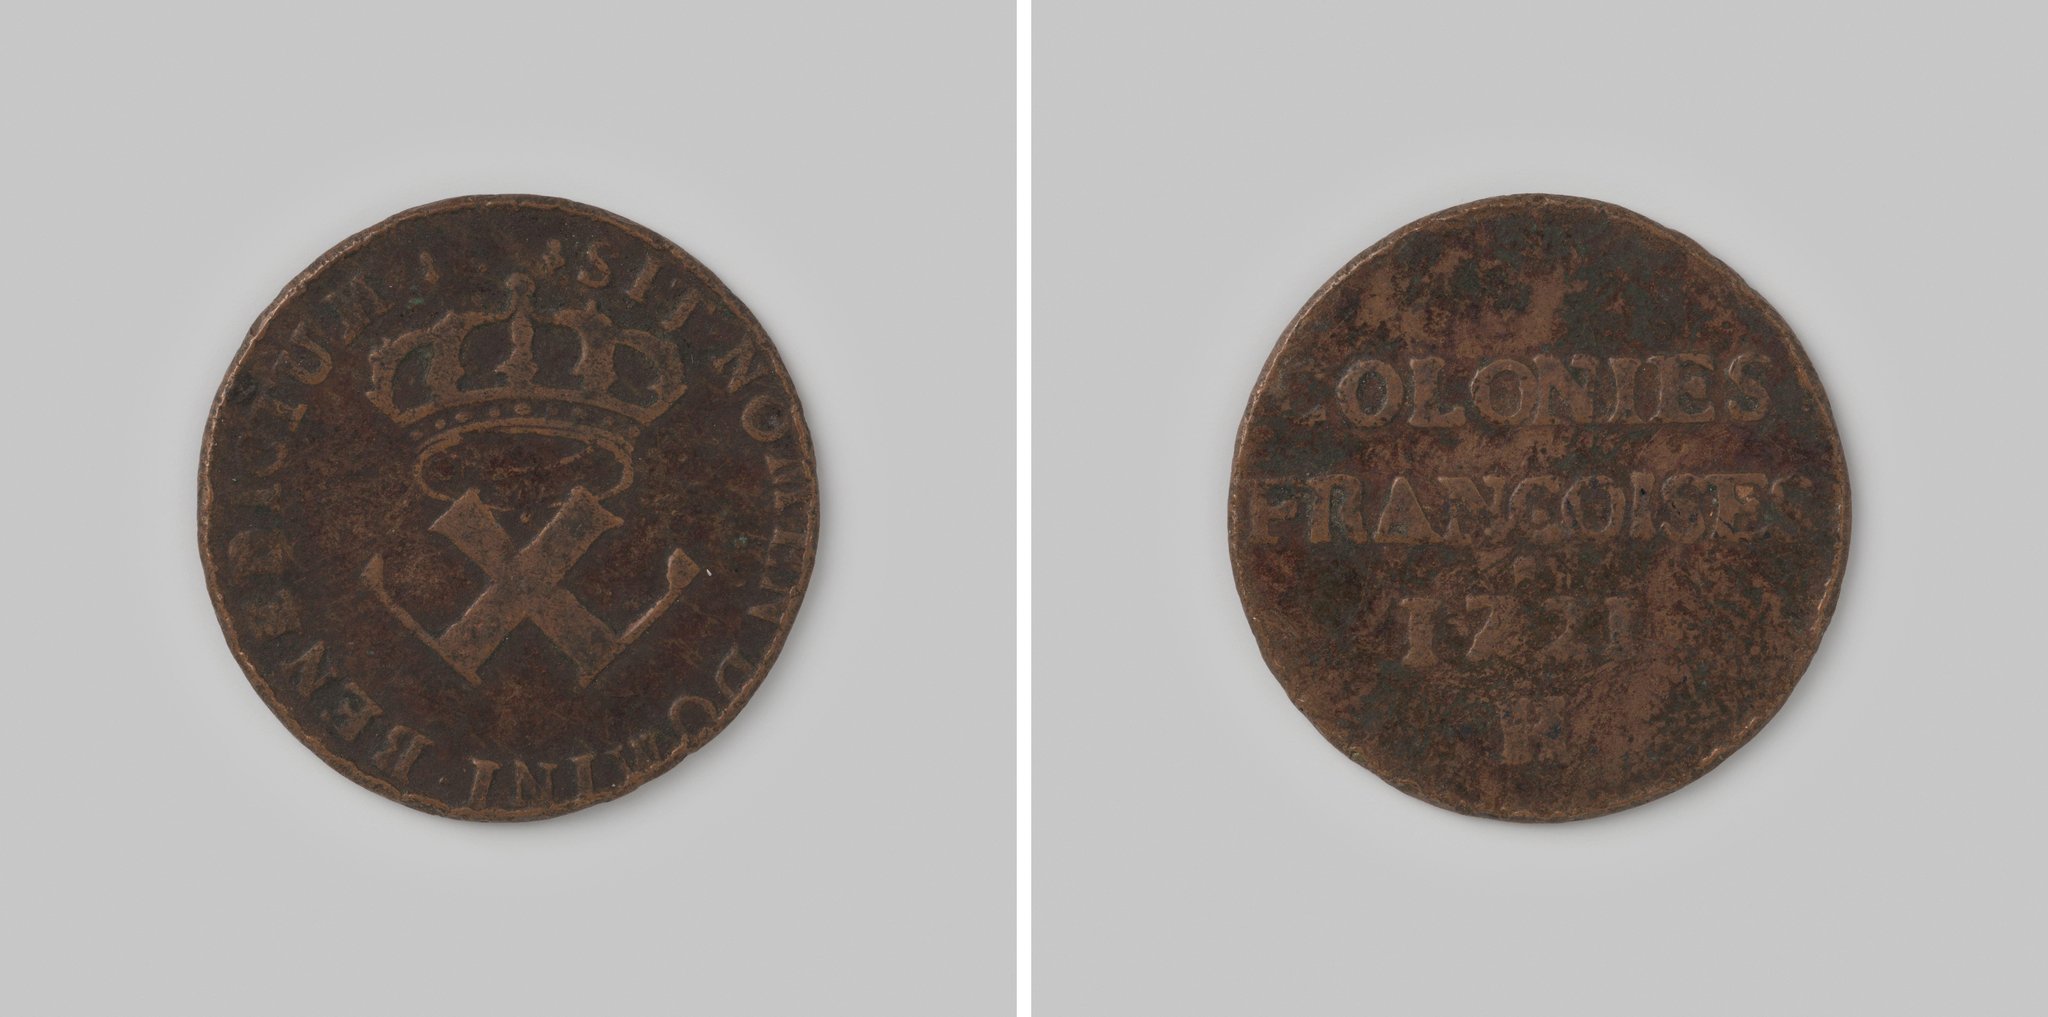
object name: coin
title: Franse koloniën, Lodewijk XV, 9 deniers, 1721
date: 1721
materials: copper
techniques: striking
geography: la rochelle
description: Koperen munt. Voorzijde: gekroond monogram van Lodewijk XV. Keerzijde: in twee regels opschrift: COLONIES FRANCOISES. Daaronder jaartal, waaronder letter H [=La Rochelle].